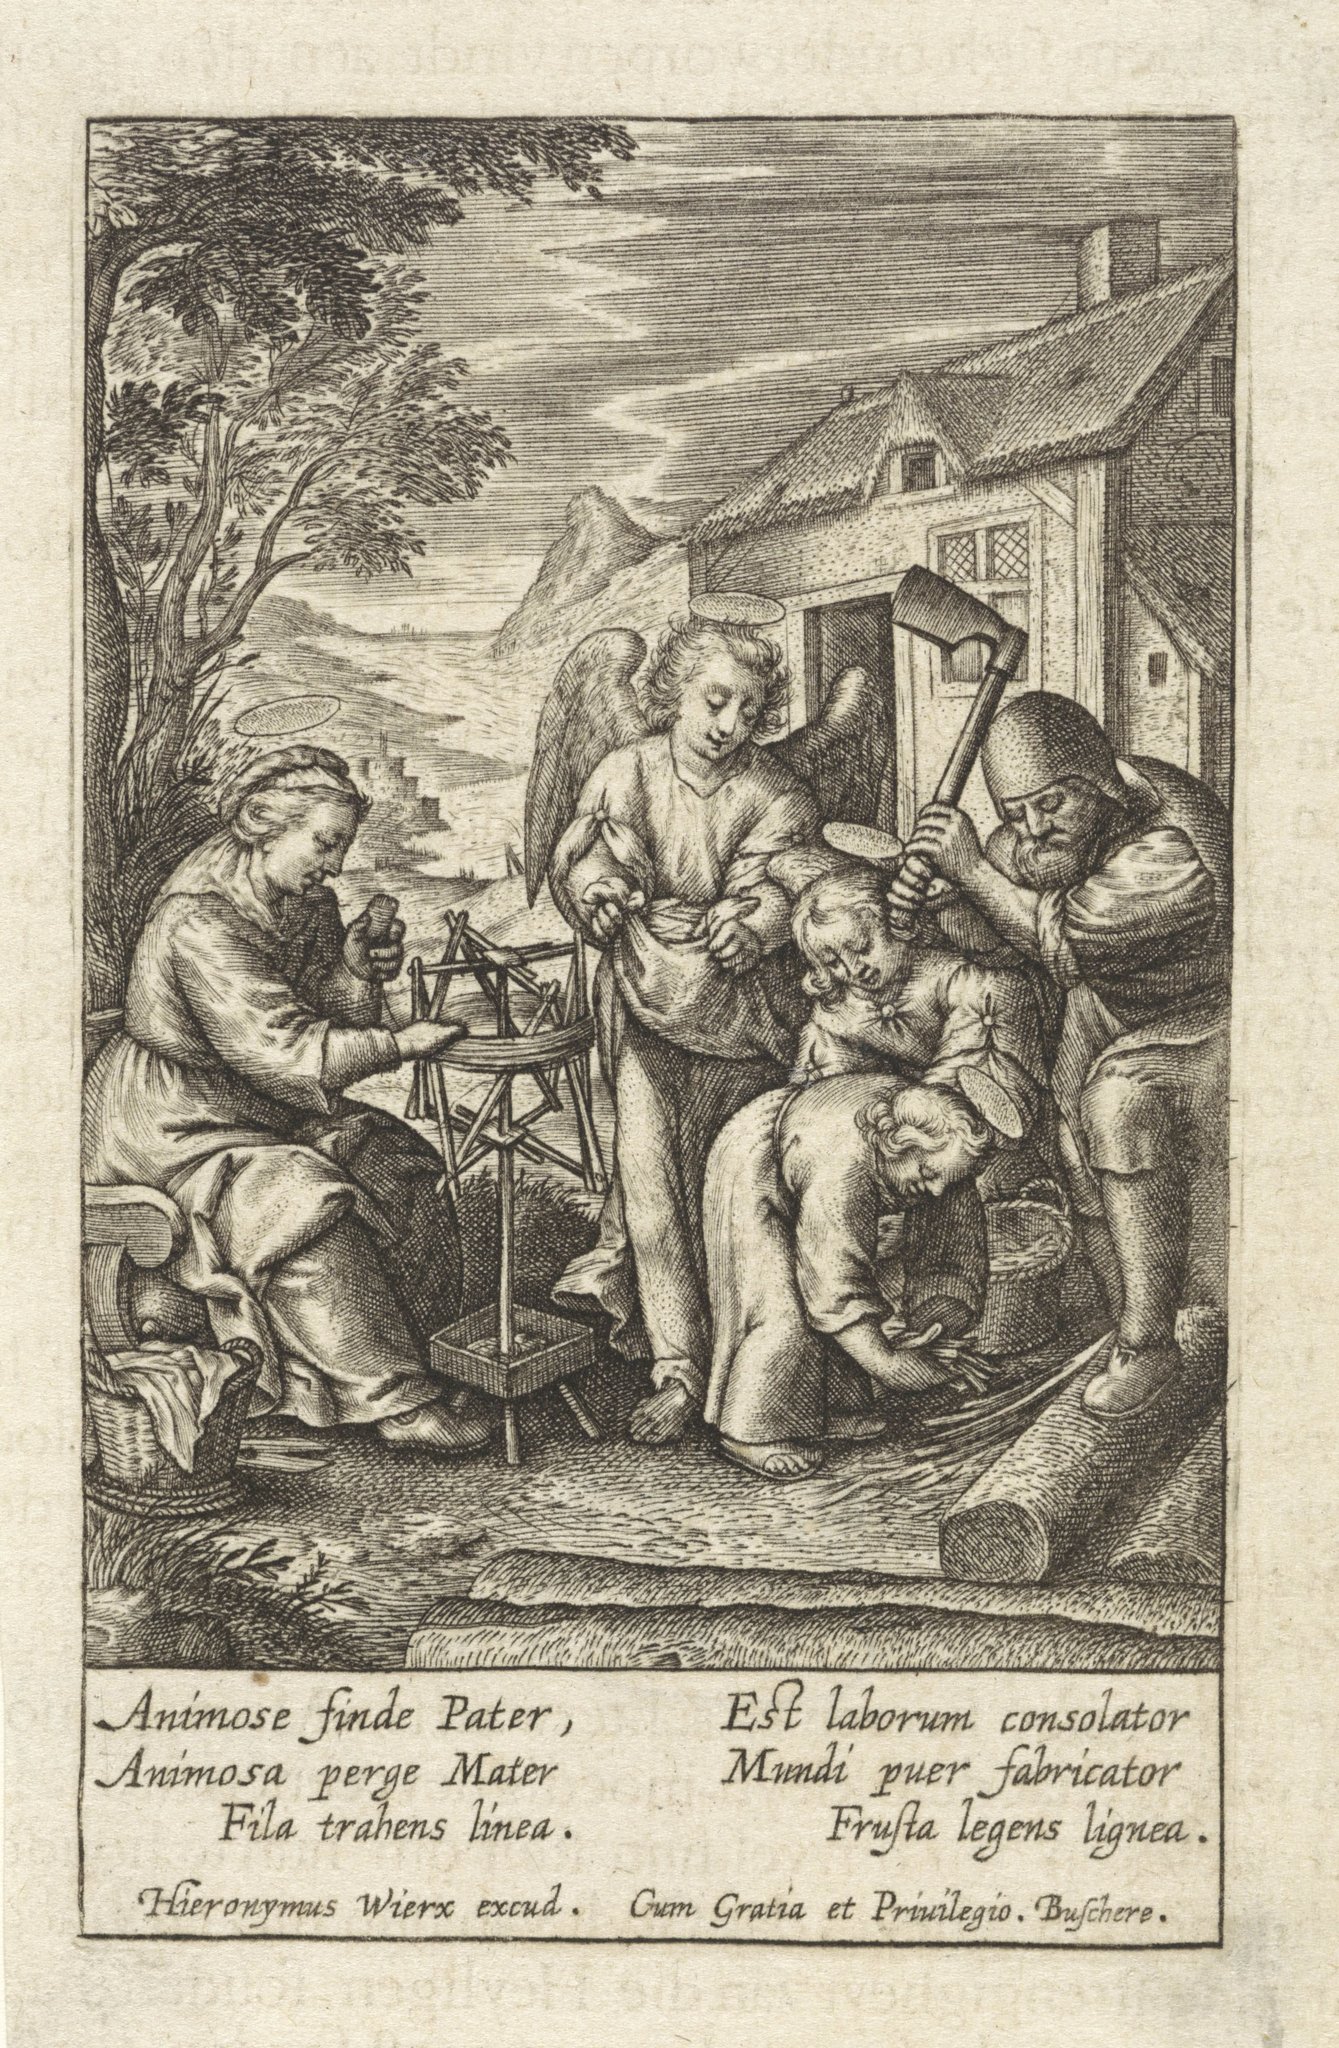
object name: print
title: Iesv Christi dei Domini, salvatoris nri infantia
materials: paper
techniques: engraving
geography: antwerp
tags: joseph and the christ-child ~ daily life in nazareth, household occupations of mary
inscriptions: collector's mark: Lugt 2228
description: Jozef hakt hout van een boomstam. Het Christuskind raapt de snippers op. Hij wordt geholpen door twee engelen die het hout in hun mantel verzamelen. Maria zit bij hen en is aan het spinnen. In de marge een zesregelig onderschrift, in twee kolommen, in het Latijn.